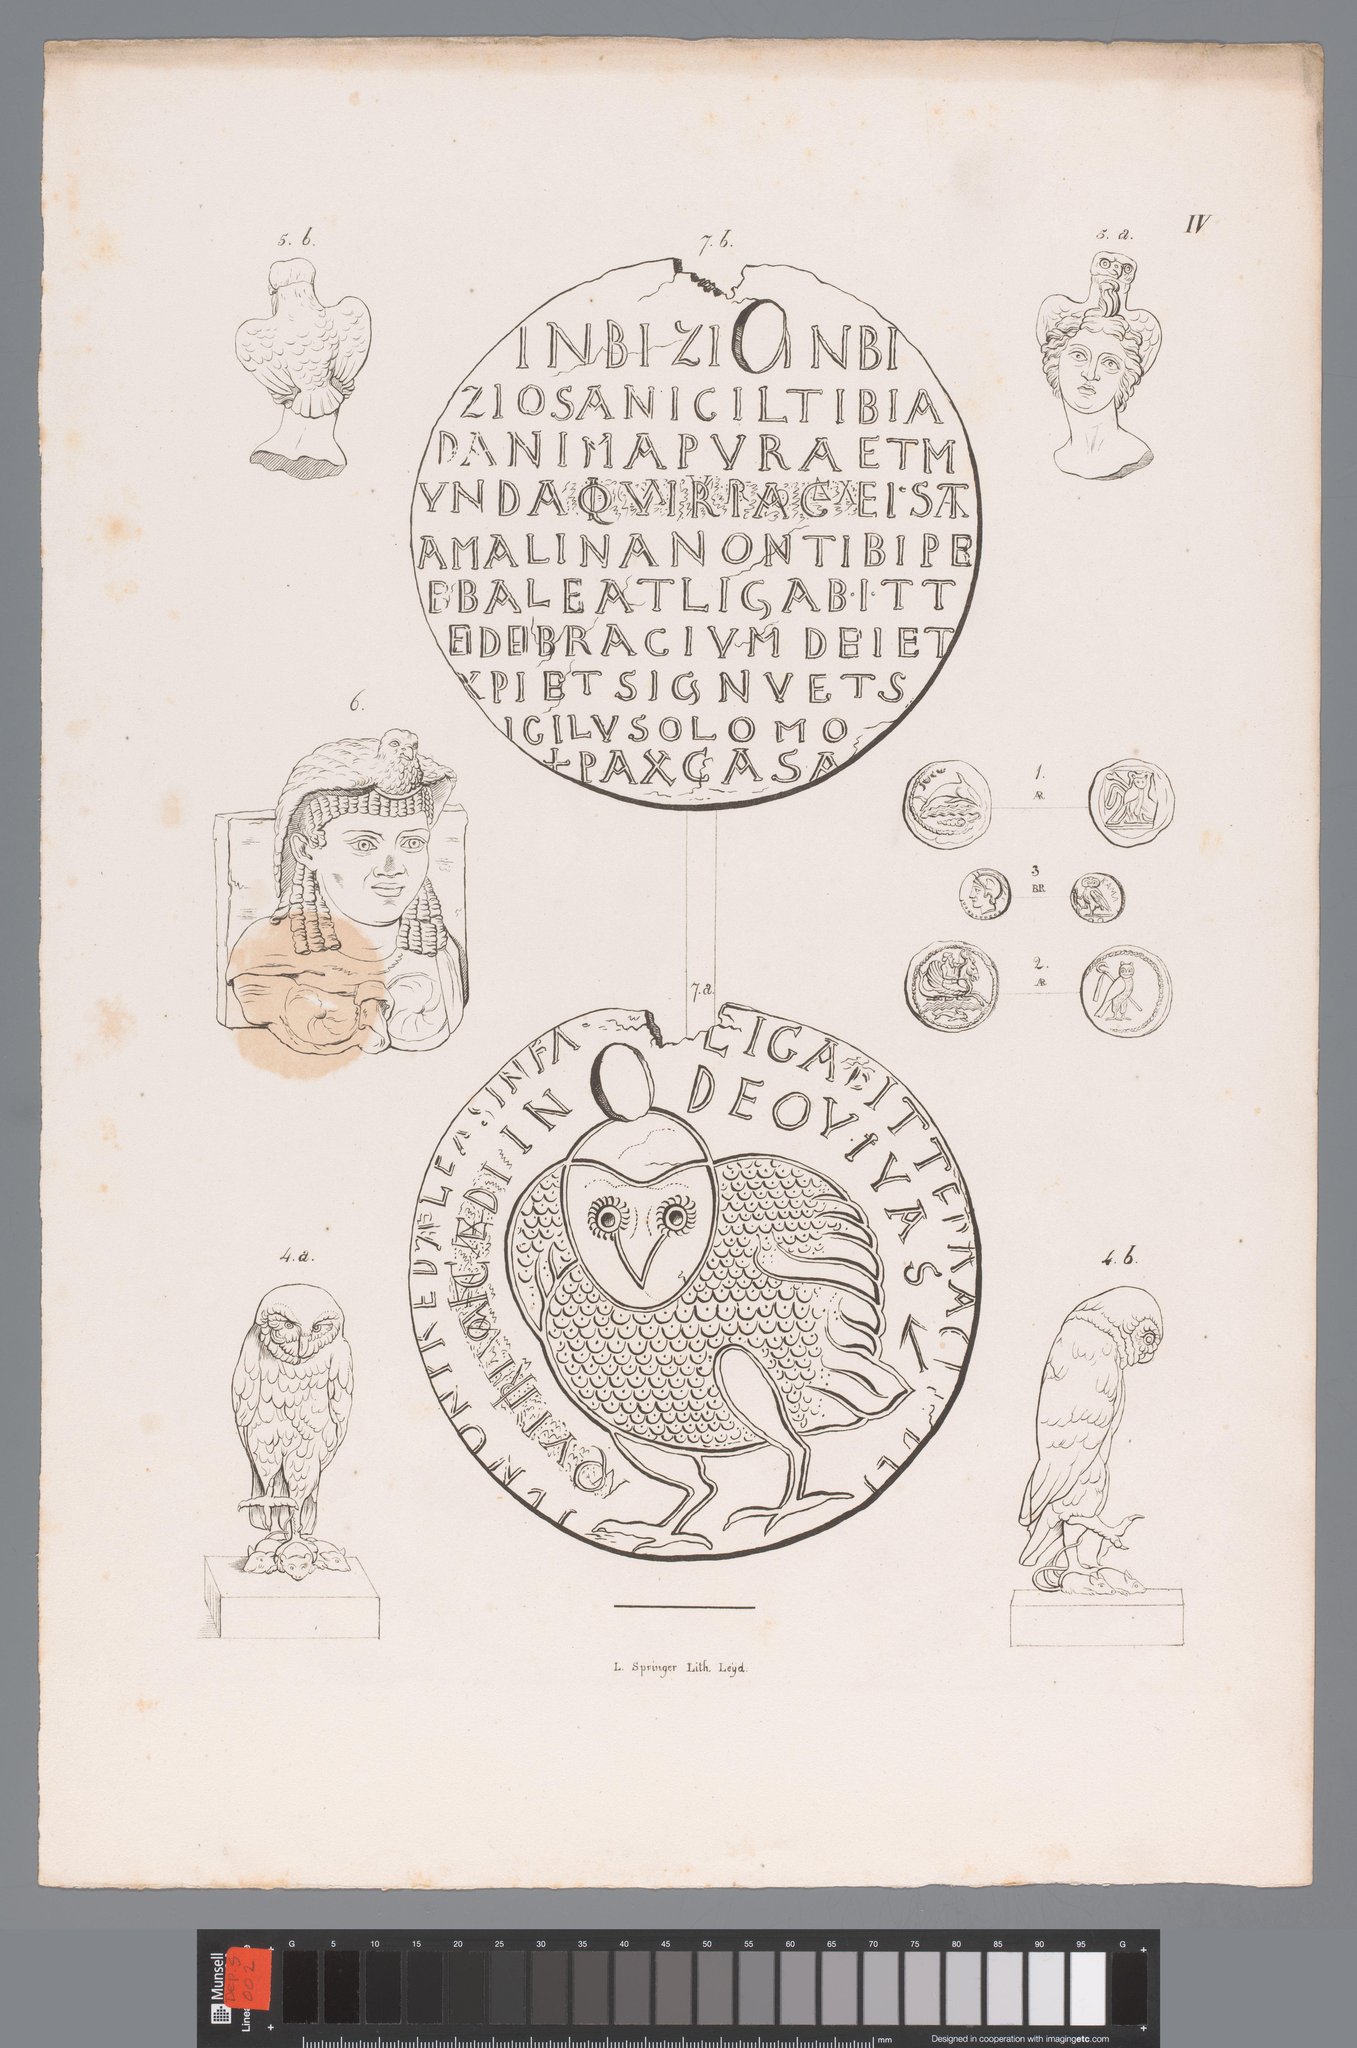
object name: book illustration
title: Munten, beeld van een uil, bustes en een inscriptie met uil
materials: paper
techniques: lithograph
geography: leiden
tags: piece of sculpture, reproduction of a piece of sculpture, owls, coin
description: Prent uit: Reuvens, Caspar Jacob Christian. Lettres à M. Letronne (...) sur les papyrus bilingues et Grecs (...) Atlas, 1830. Nummer 7 is naar een inscriptie in de collectie van het Rijksmuseum van Oudheden te Leiden (inventarisnr. GS-11128).